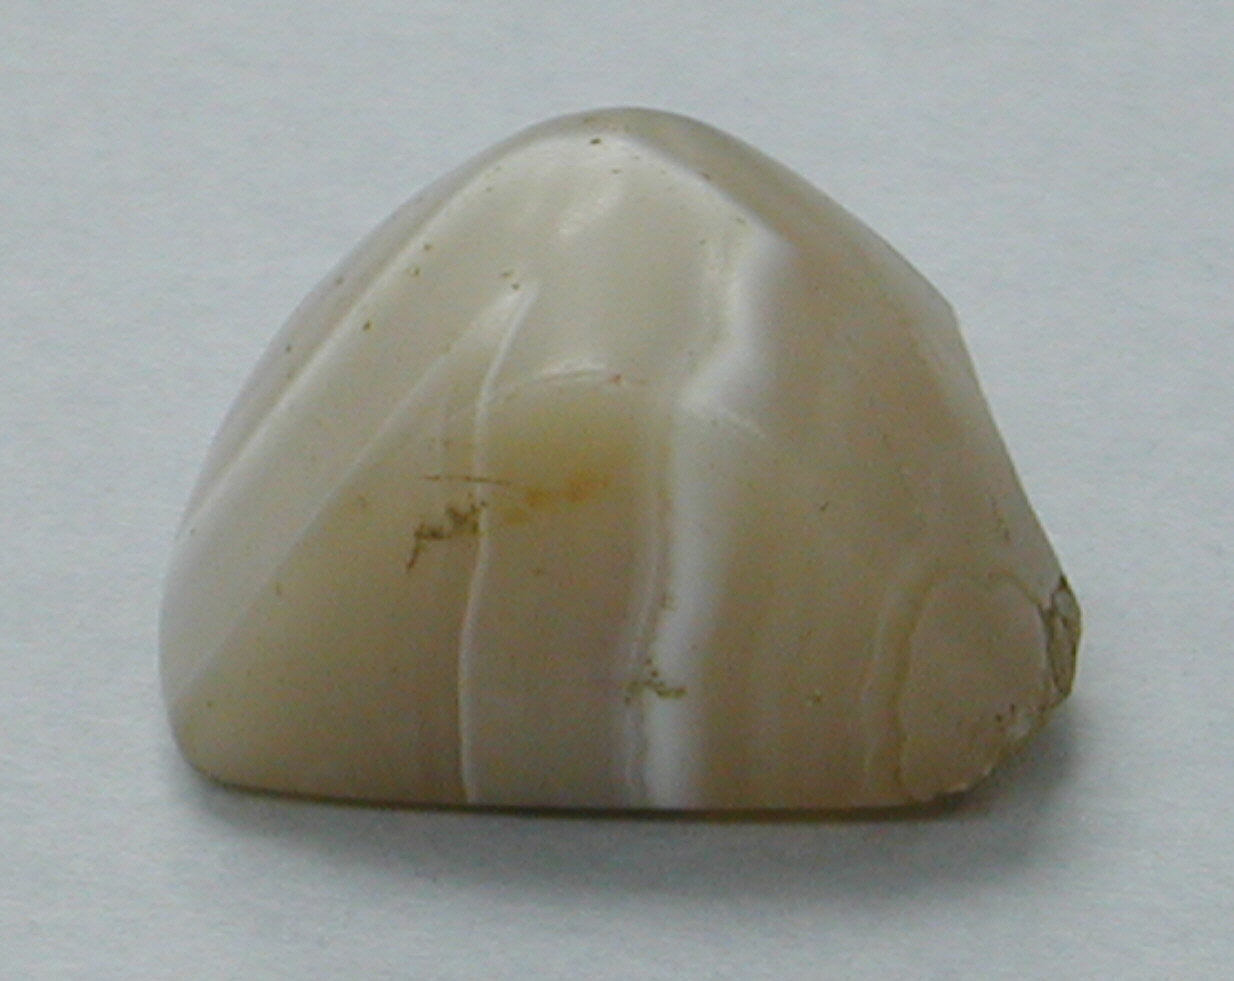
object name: ritual stone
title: Stone Pulidor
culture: mexican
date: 1501-1600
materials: stone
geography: mexico